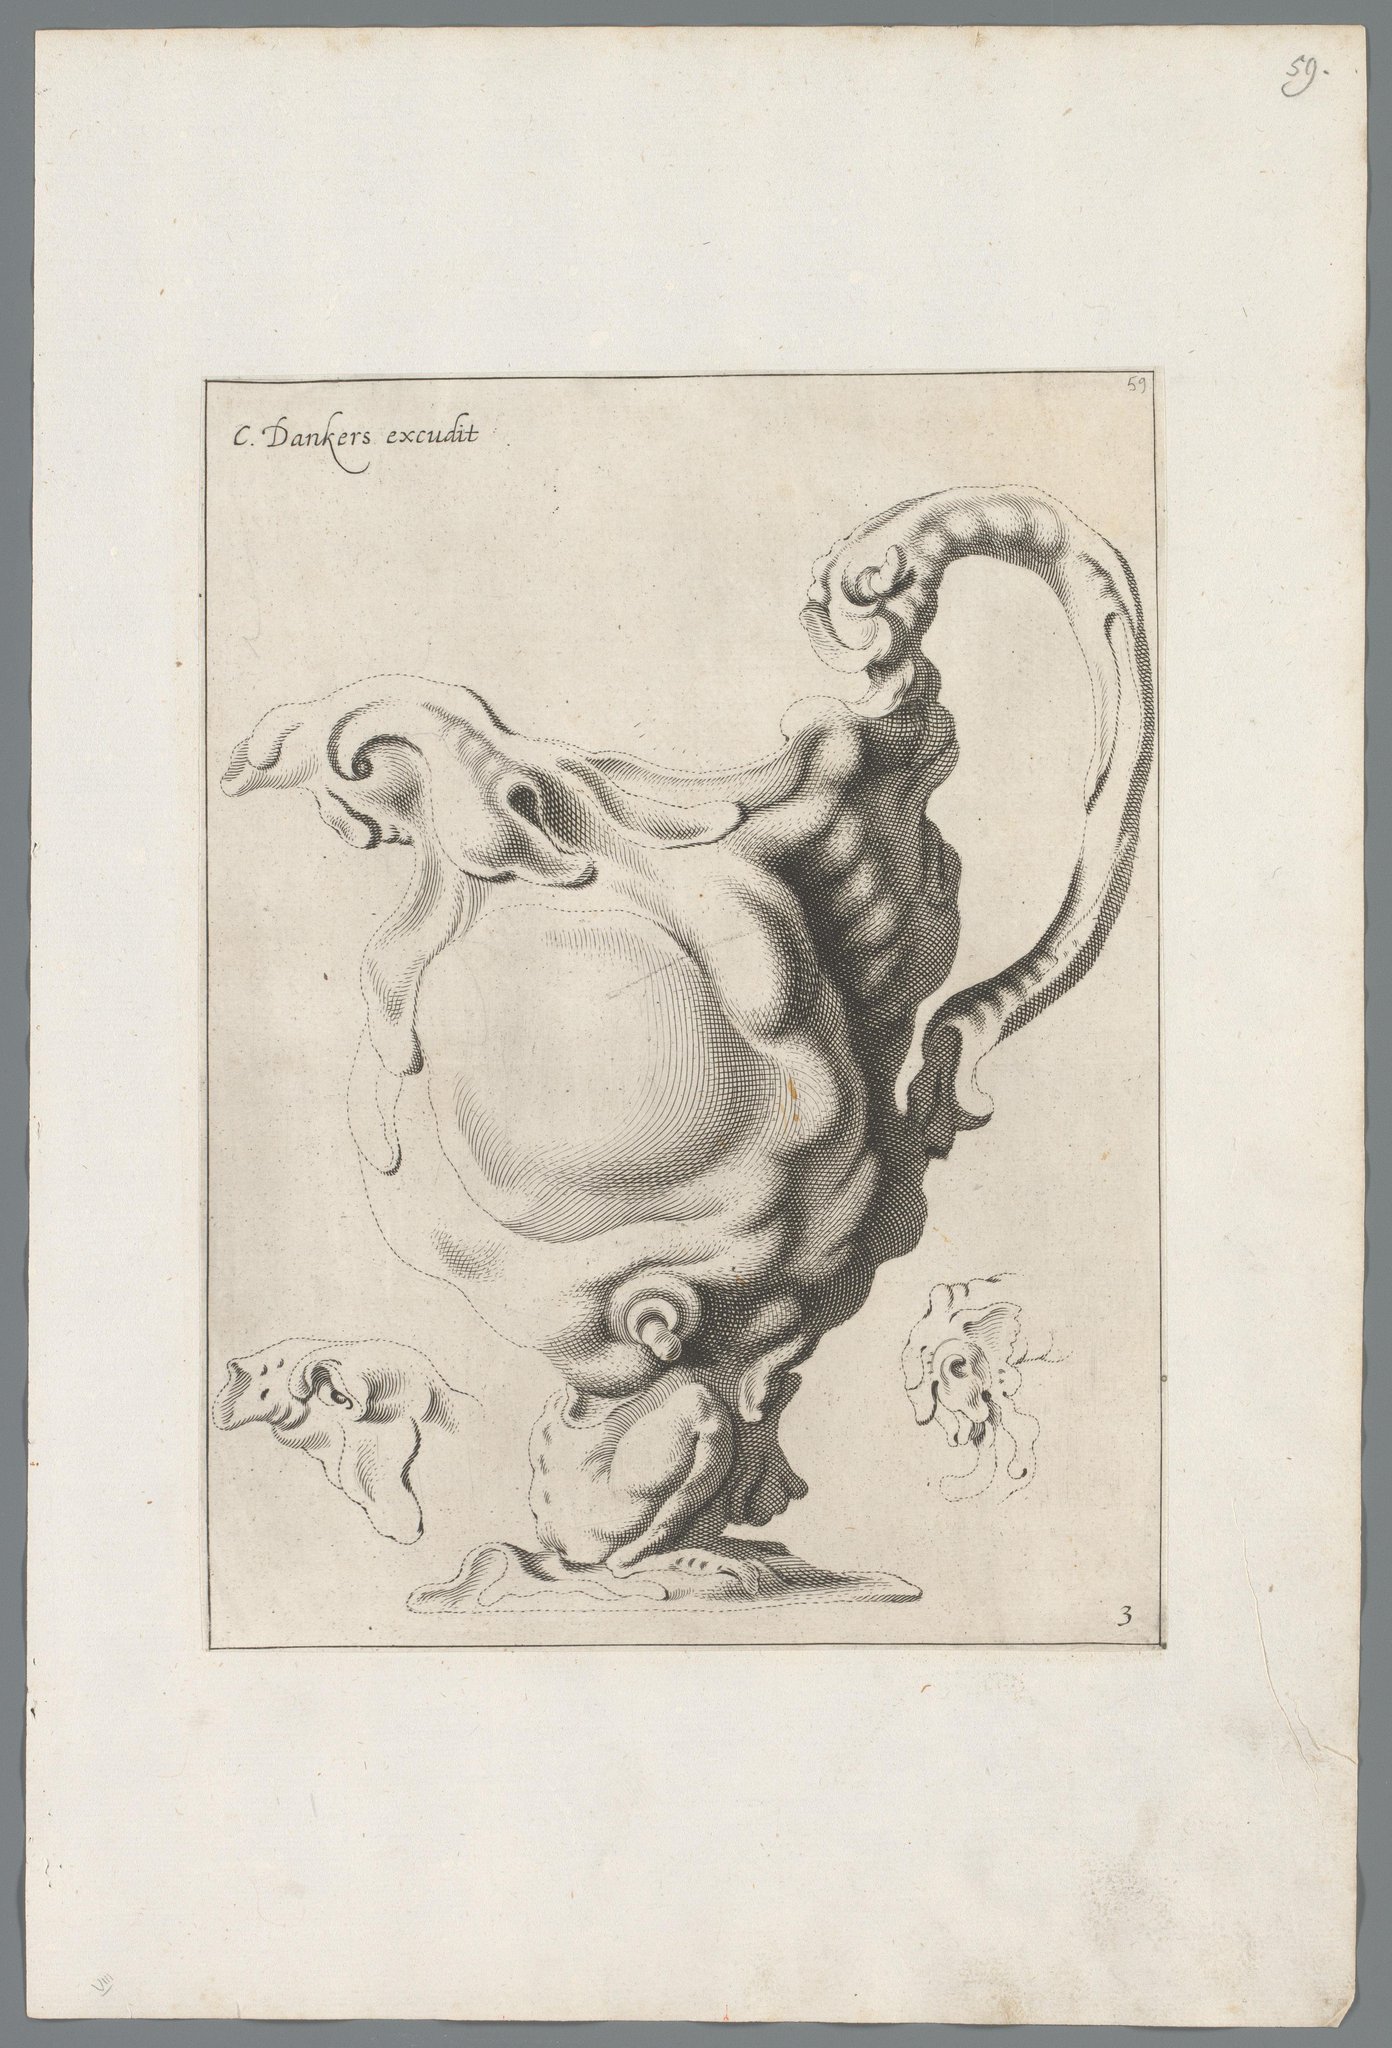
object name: ornament print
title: Ontwerpen om in goud, zilver, hout en steen uit te werken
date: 1651-1653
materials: paper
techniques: engraving, etching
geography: amsterdam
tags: container of metal: bucket, can, canister, drum, tin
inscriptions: collector's mark: Lugt 2760, collector's mark: Lugt 2228